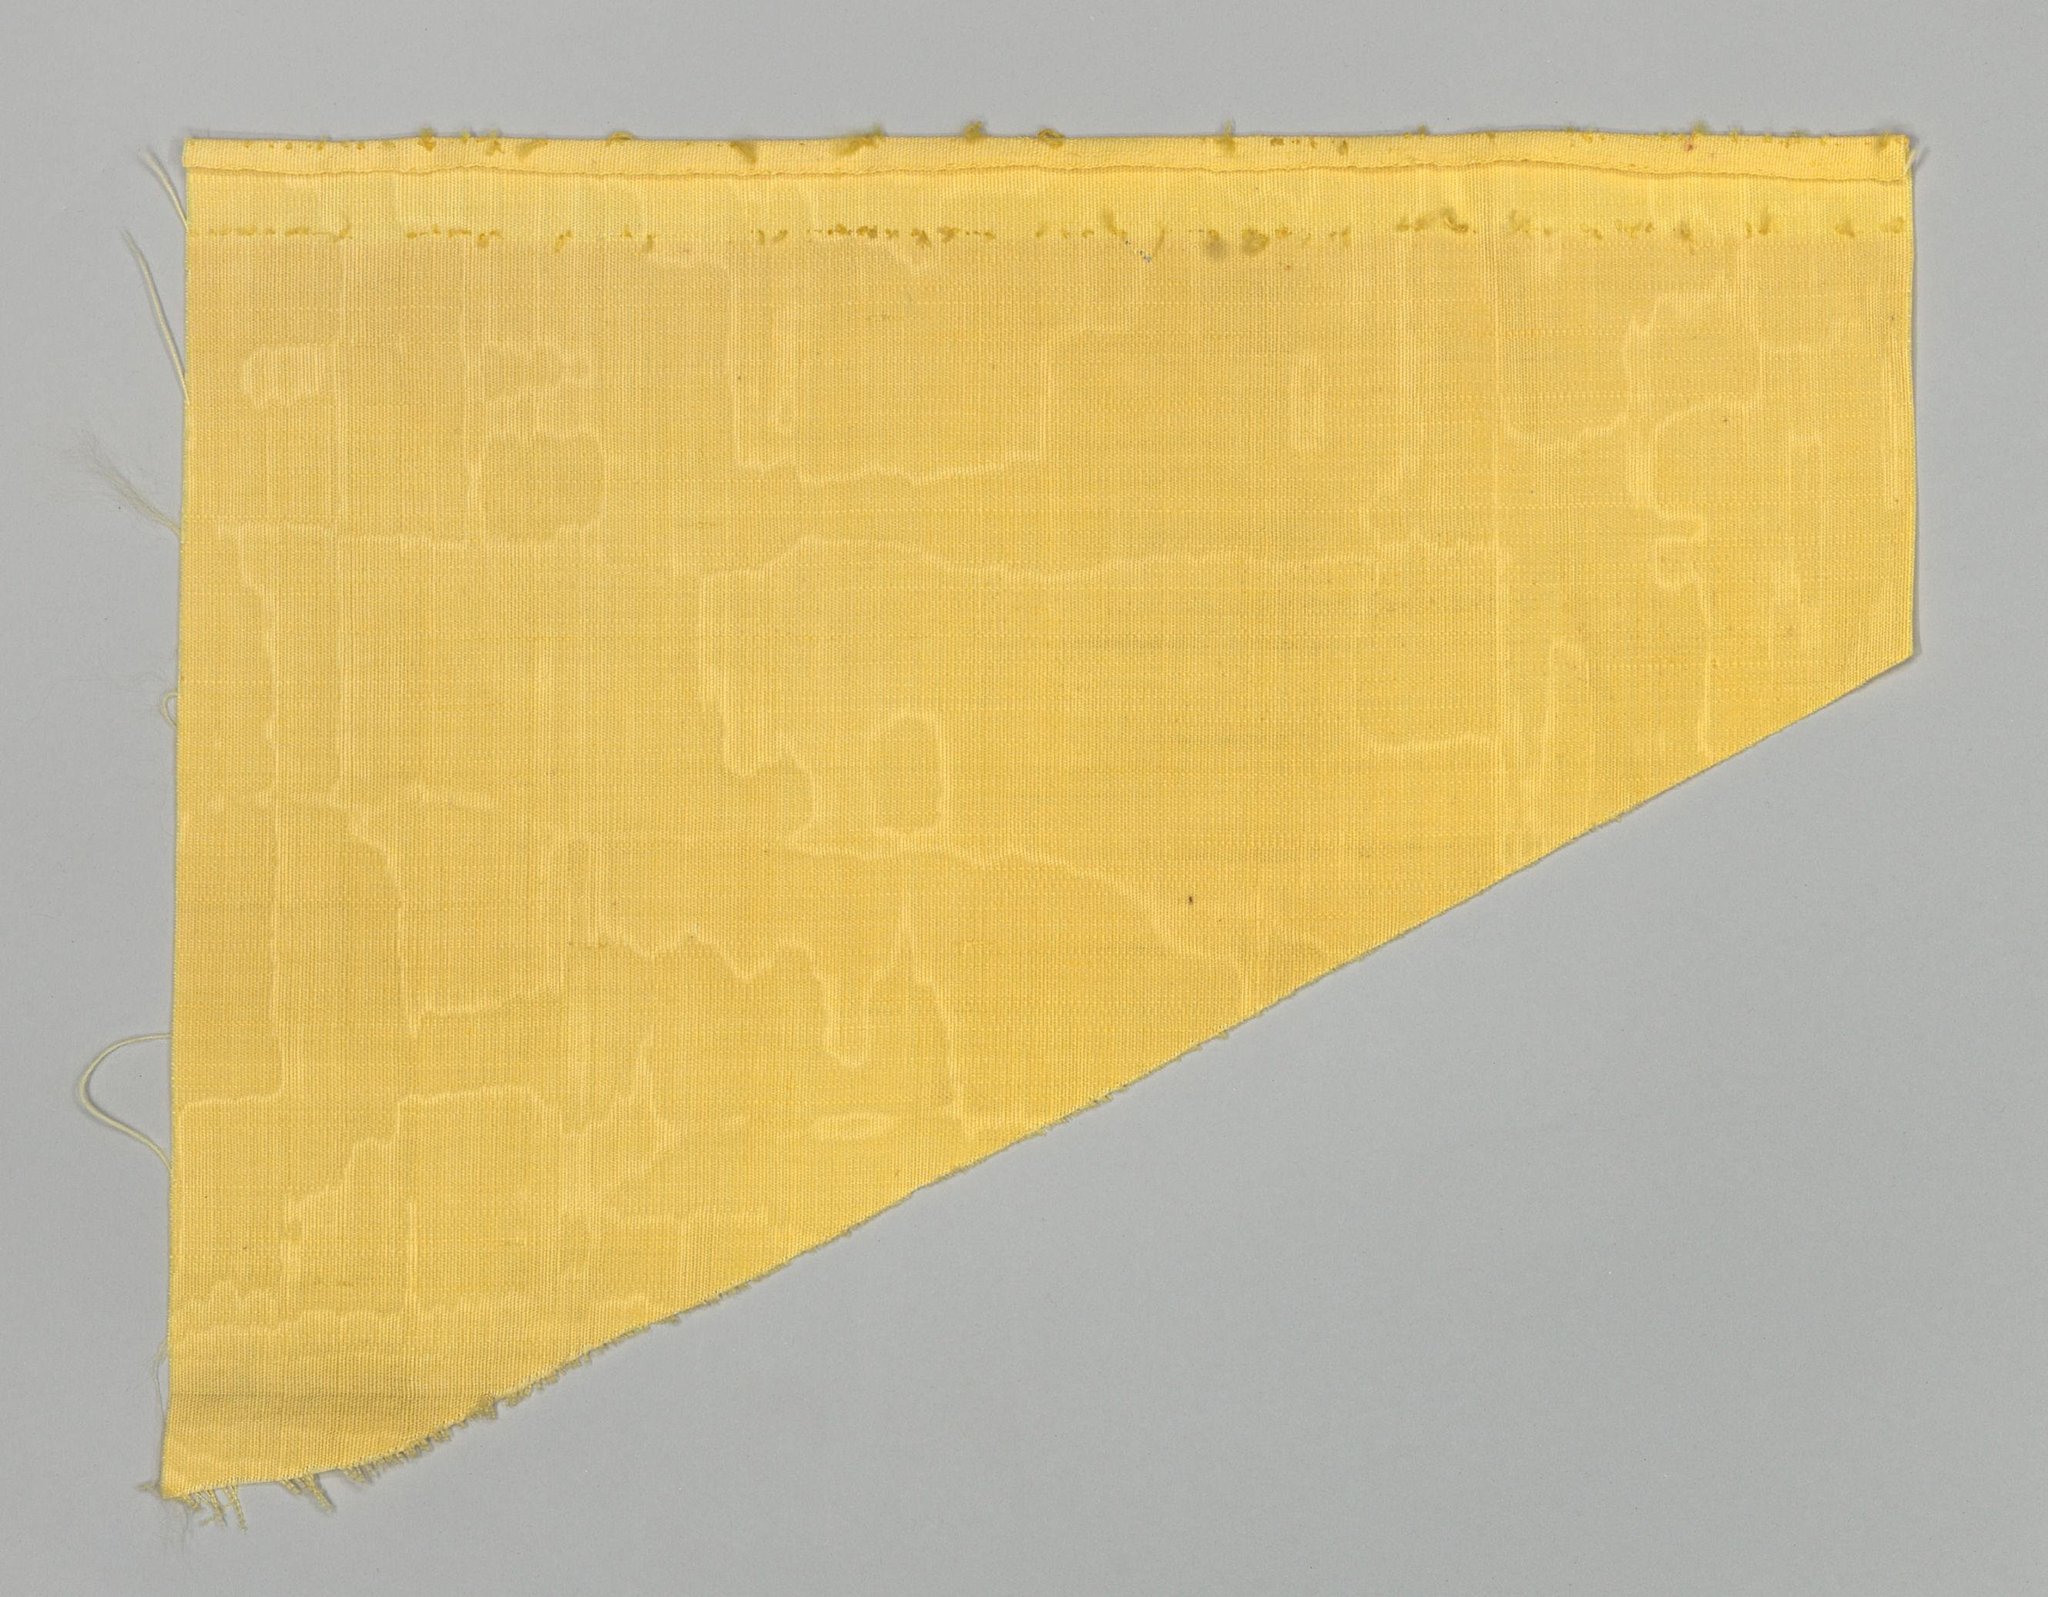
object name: fragment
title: Fragment van een bedgarnituur van gele gewaterde wol met groen passement en afhangende klosjes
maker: Anonymous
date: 1795-1815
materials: wool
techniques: moire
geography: northern netherlands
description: Fragment van een bedgarnituur van gele gewaterde wol, omboord met groen passement met een geel motief en met een groen en geel boordsel met afhangende klosjes die met gele en groene zijde zijn omwonden.